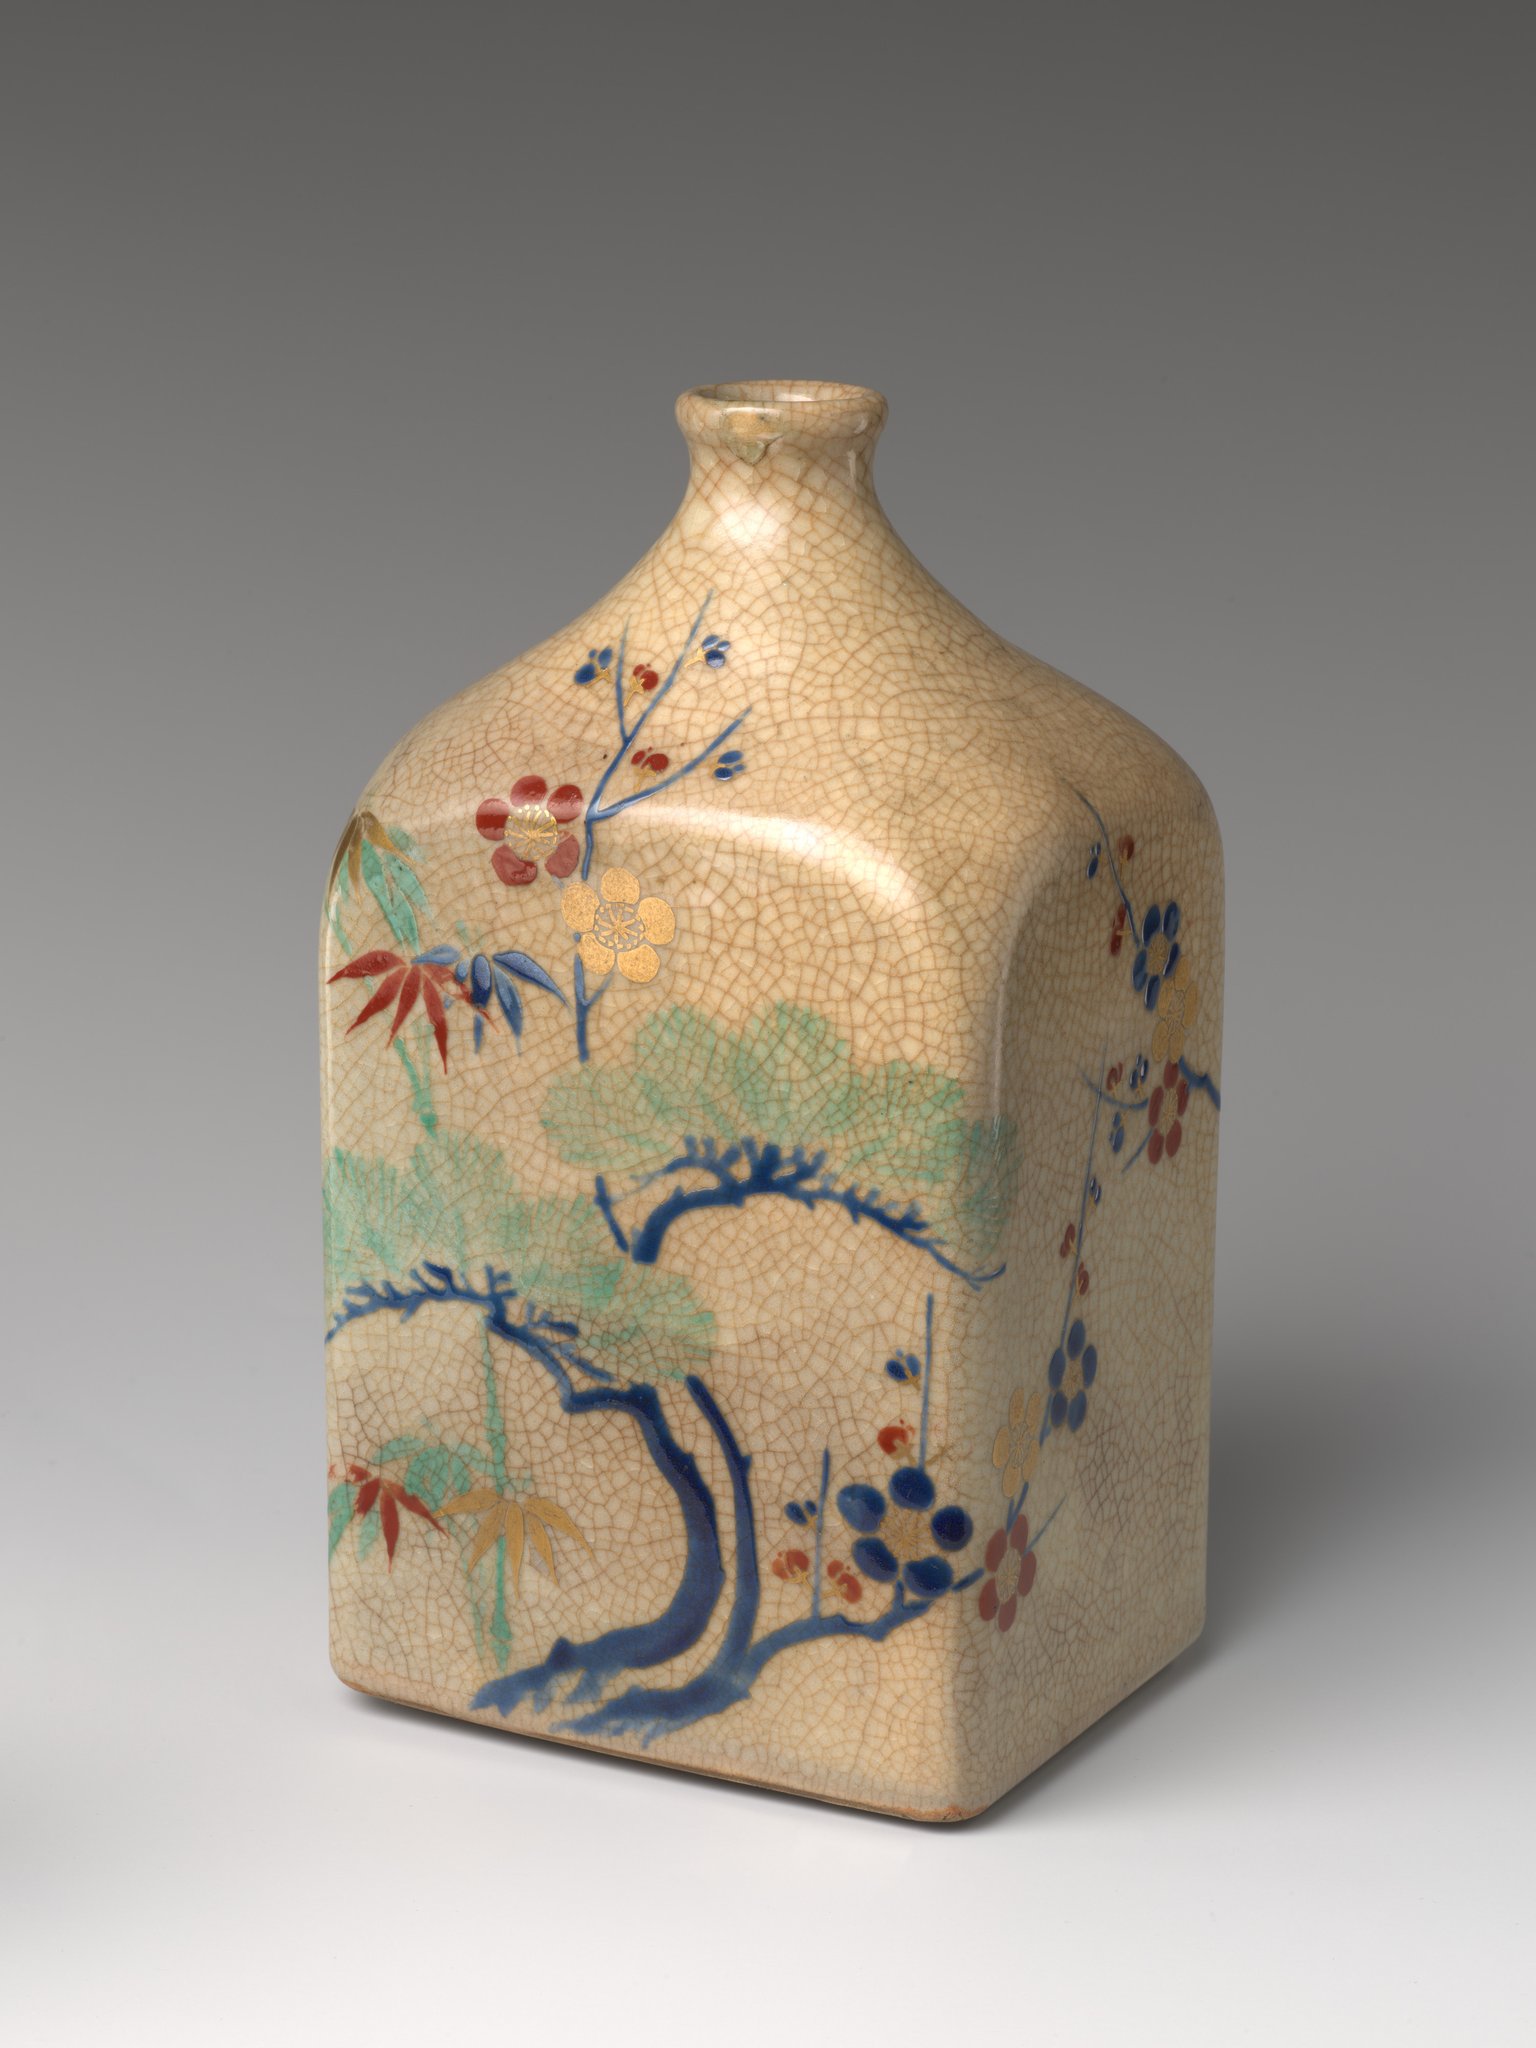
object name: sake bottle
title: Sake Bottle (Tokkuri) with “Three Friends of Winter” (Pine, Bamboo, and Plum)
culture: japanese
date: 1701-1800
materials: enamel, stoneware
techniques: overglaze, polychrome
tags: trees